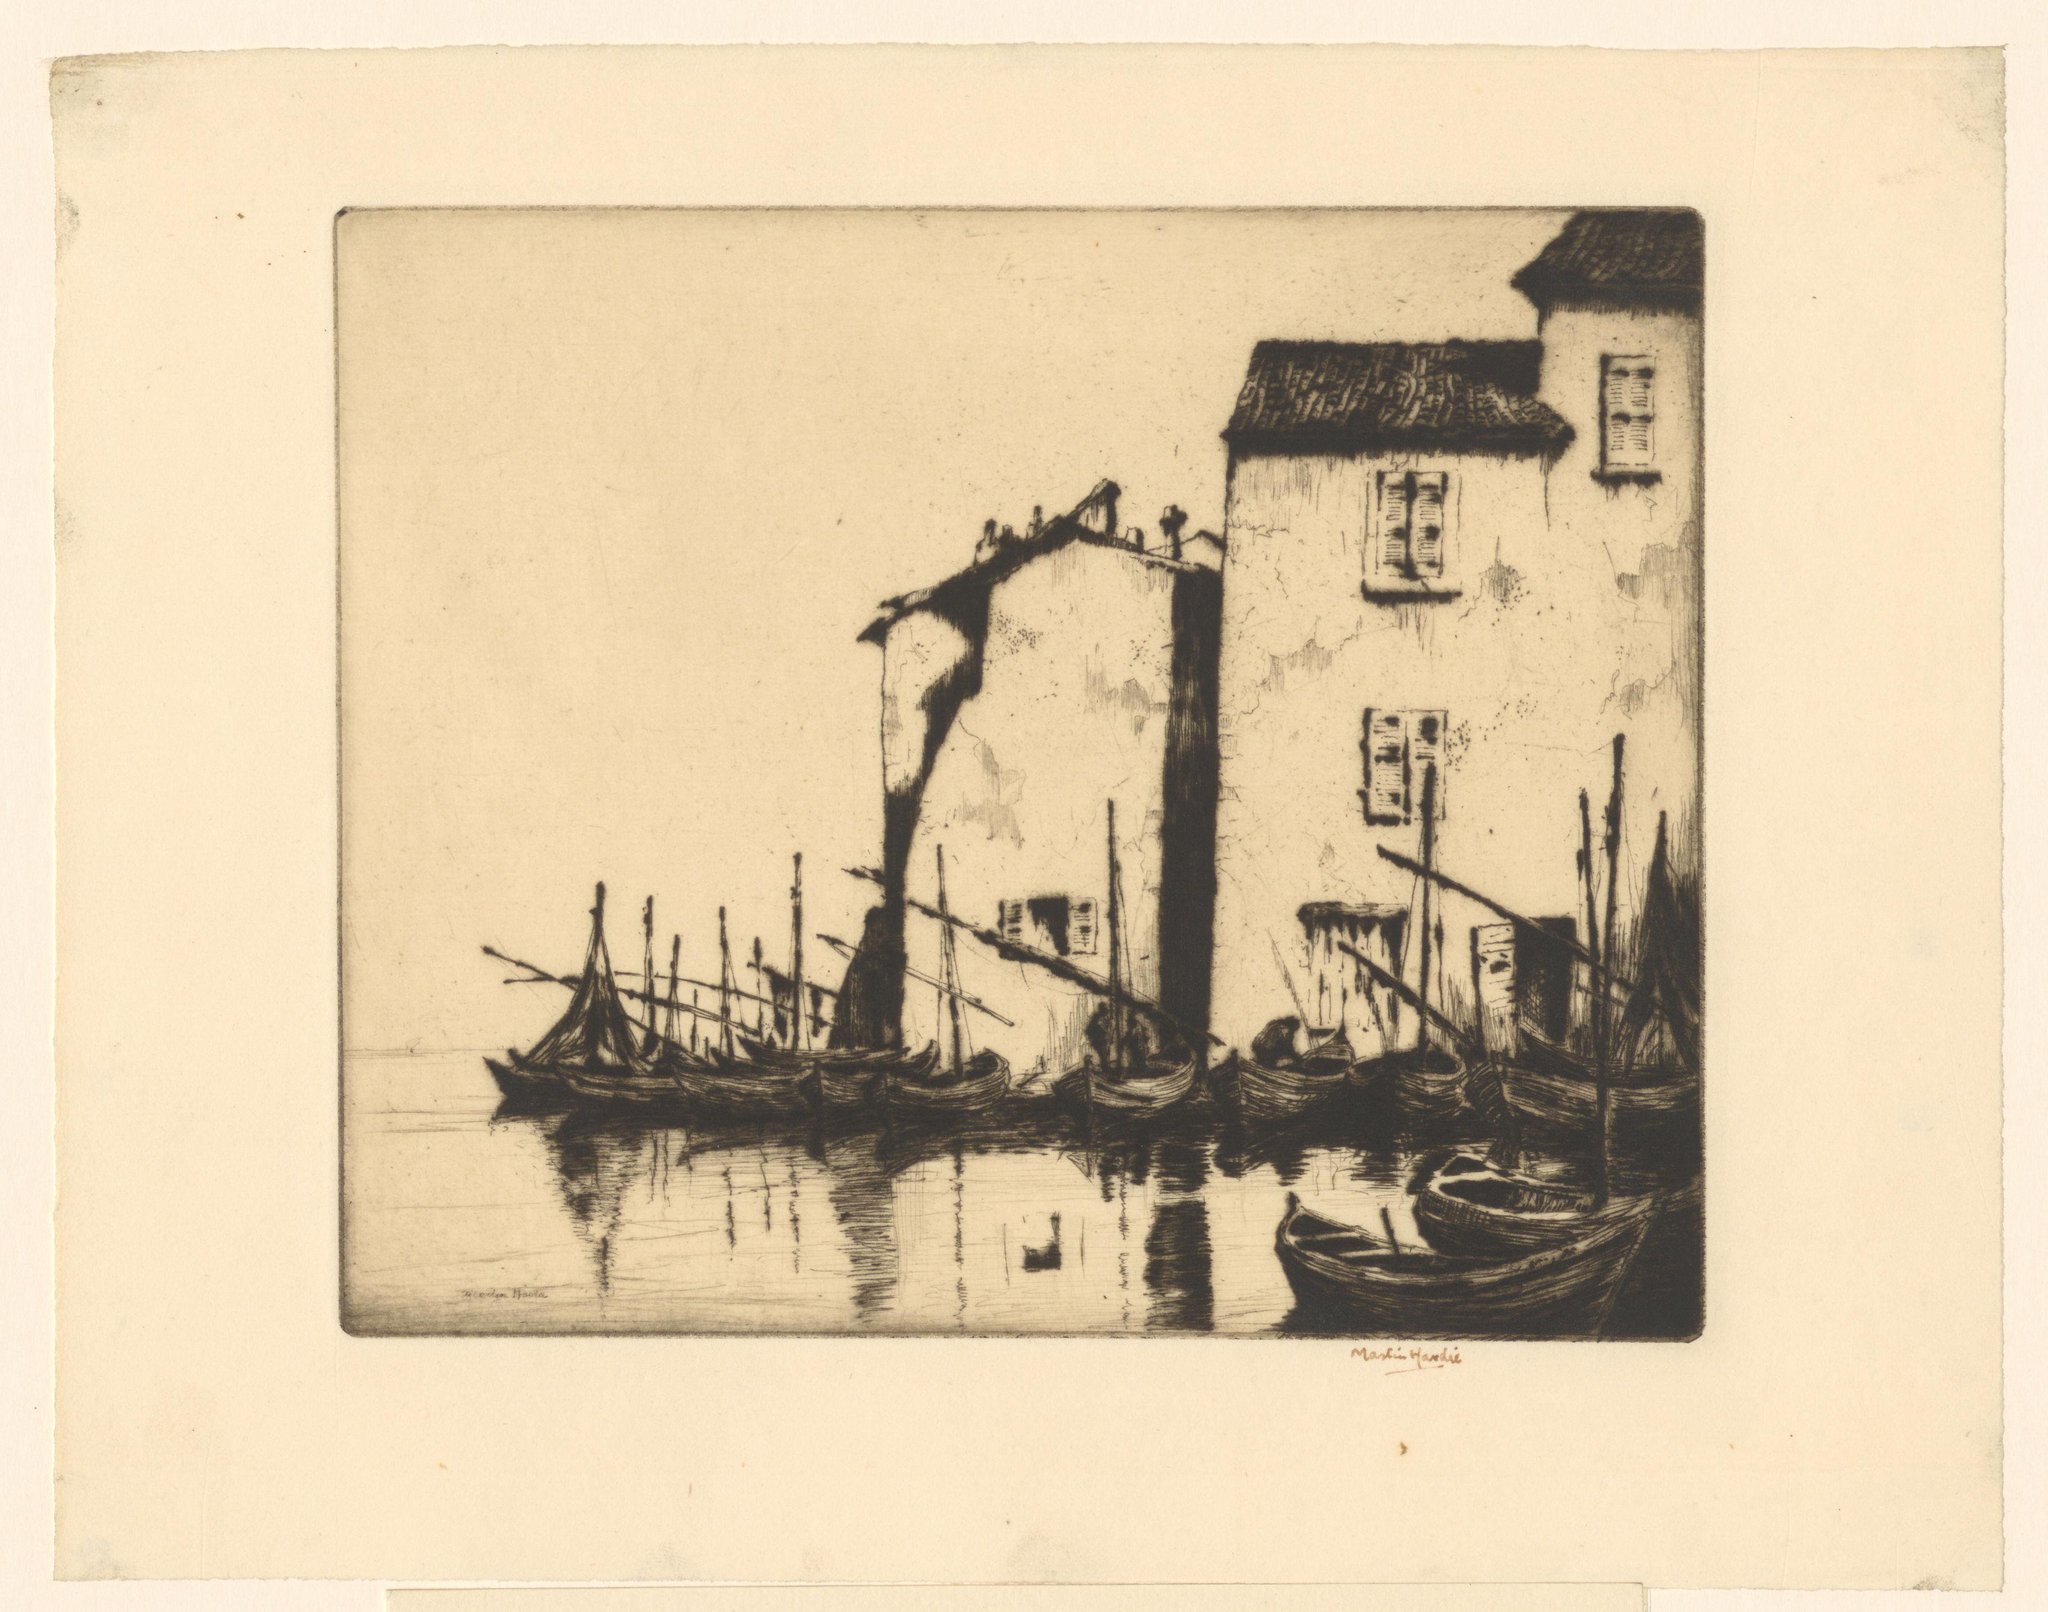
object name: print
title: Aanlegplaats met boten bij Martigues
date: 1921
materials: paper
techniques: drypoint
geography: martigues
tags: sailing-ship, sailing-boat, city-view in general; 'veduta'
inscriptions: collector's mark: Lugt 2760, collector's mark: Lugt 2228, annotation: ‘Martin Hardie’